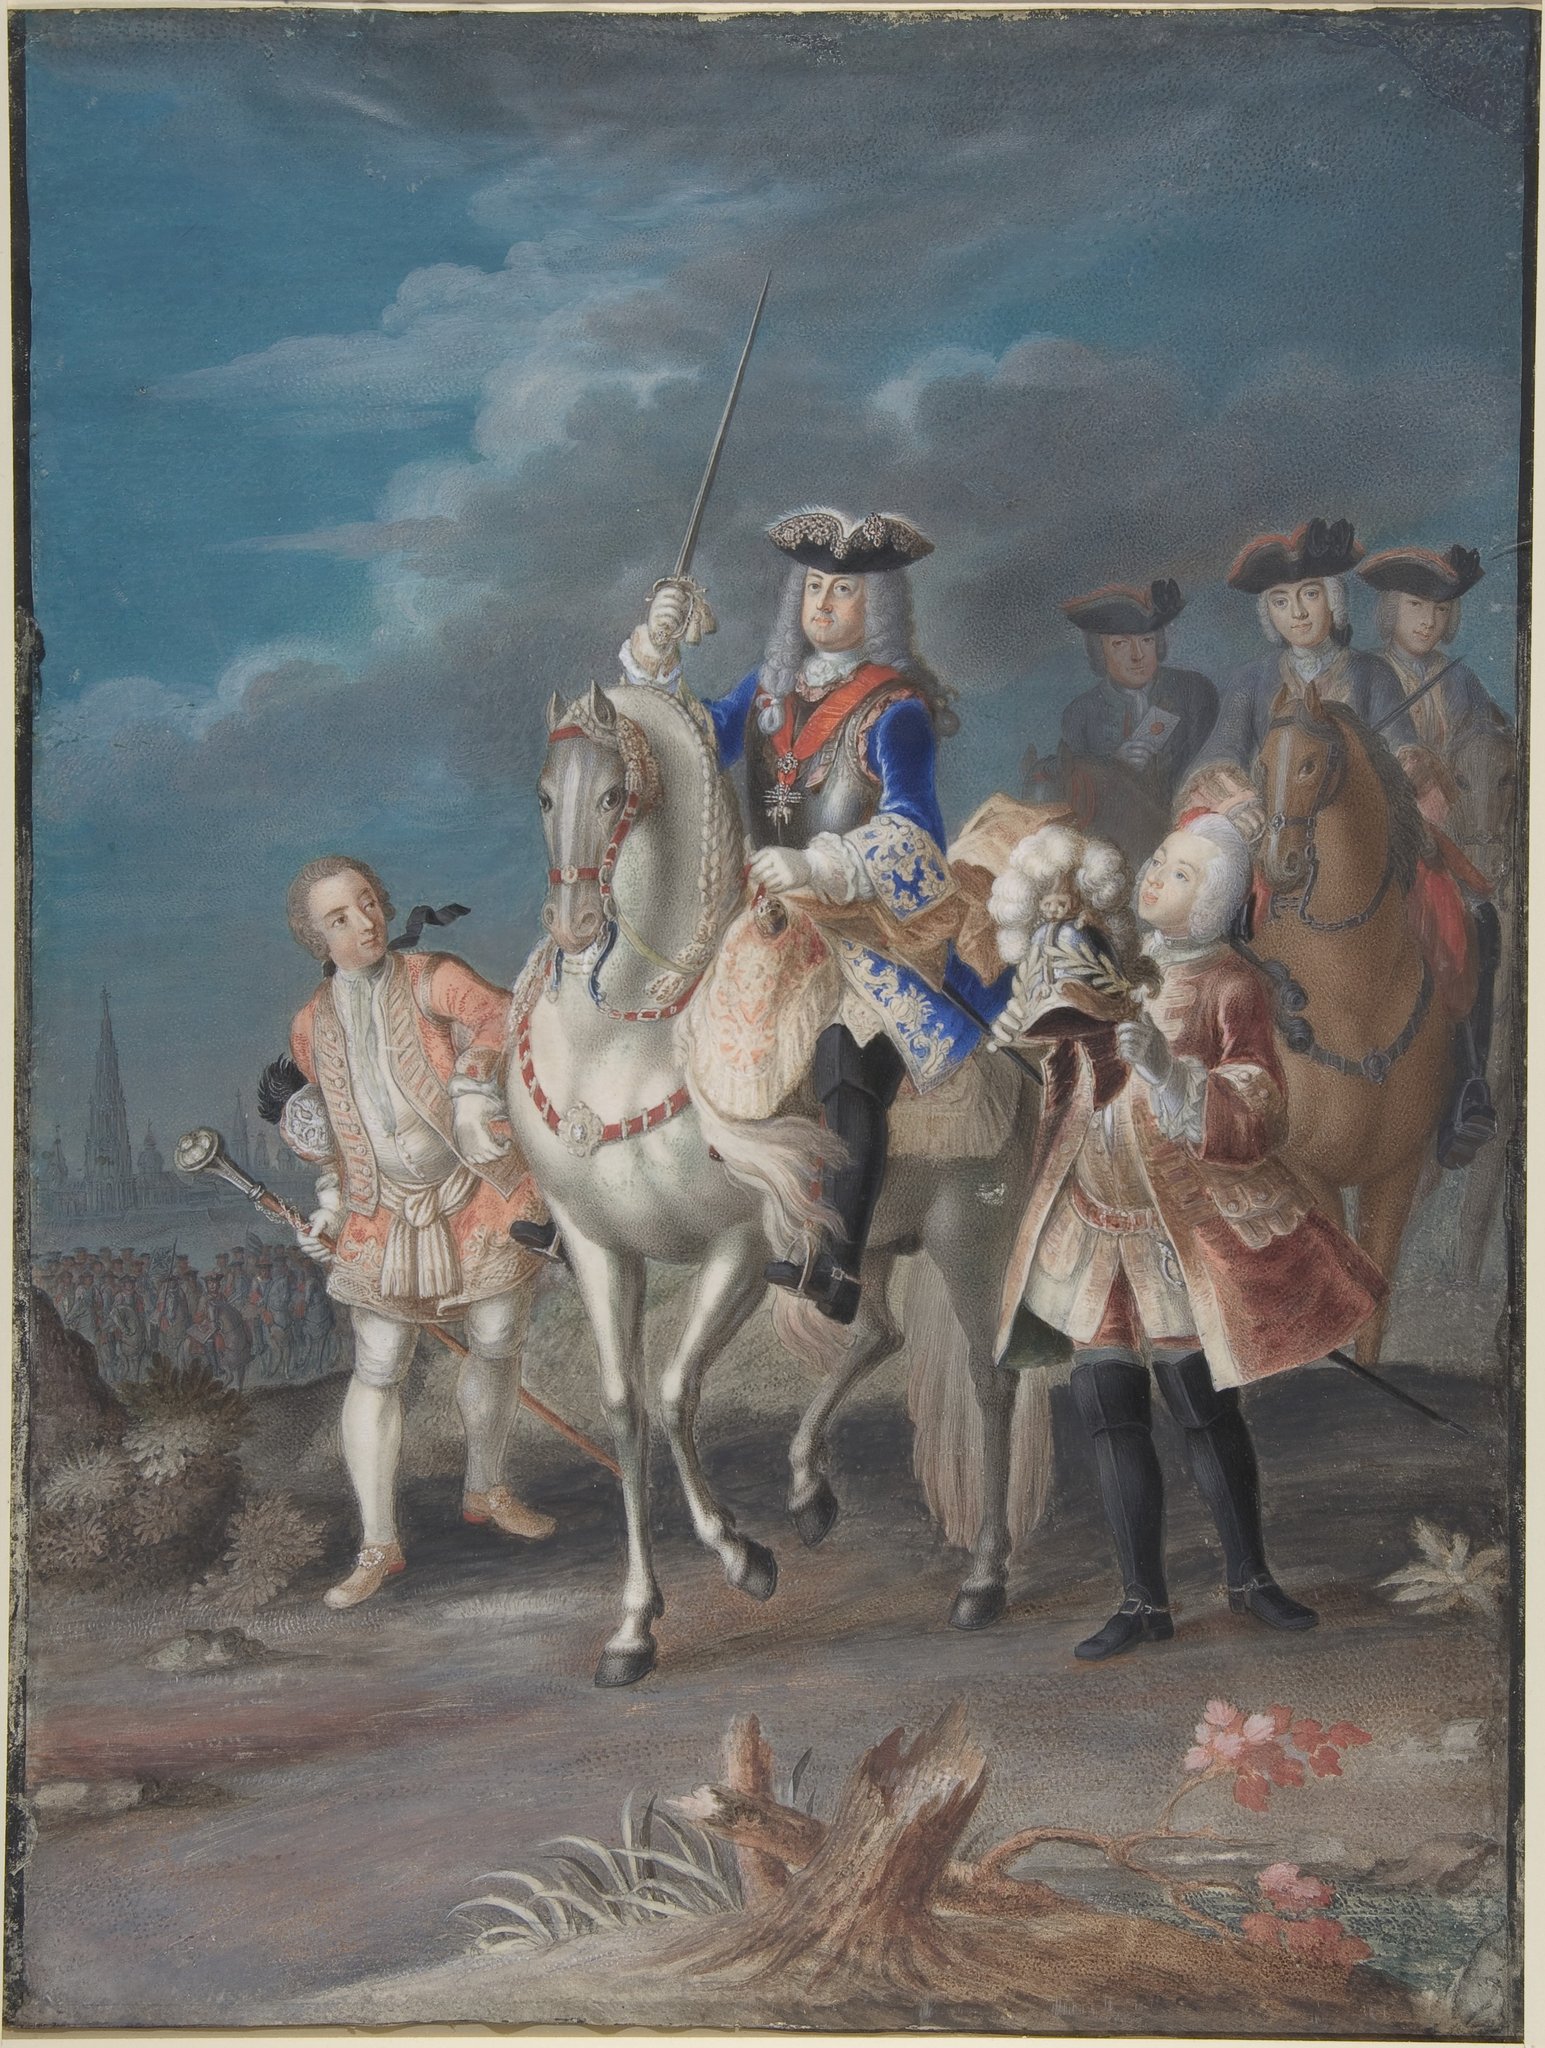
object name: drawing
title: Portrait of the consort of Maria Theresa, queen of Hungary and Bohemia, on horseback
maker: anonymous, french, 18th century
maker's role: artist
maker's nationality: french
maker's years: 1700-1800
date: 1701-1800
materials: parchment, watercolor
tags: swords,kings,men,horses